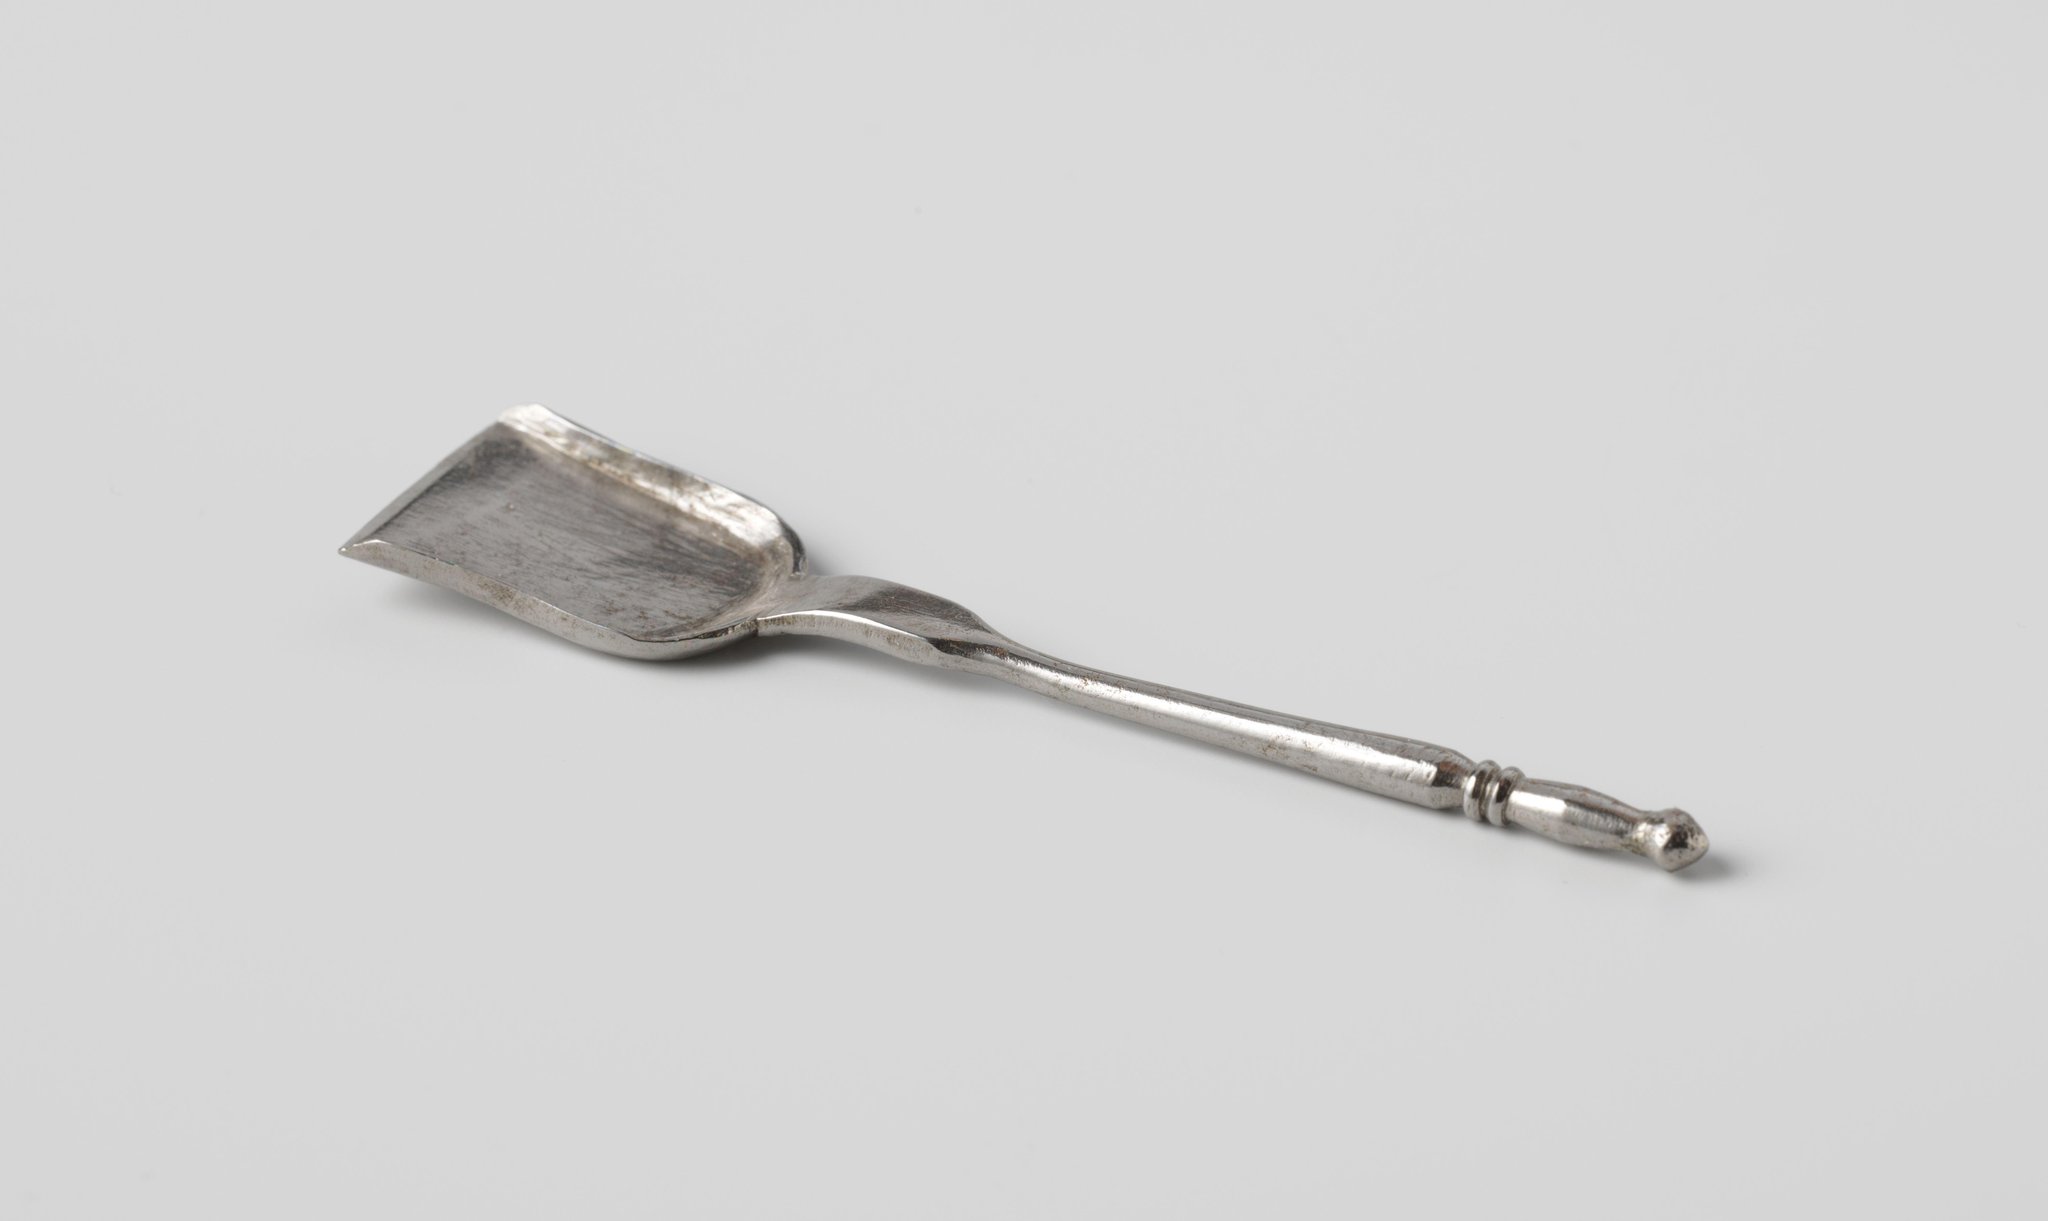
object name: ash shovel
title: Asschep met ronde steel met ringversiering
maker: Anonymous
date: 1700-1799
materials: iron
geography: amsterdam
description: Asschep van ijzer, met ronde steel met ringversiering eindigend in een knop.